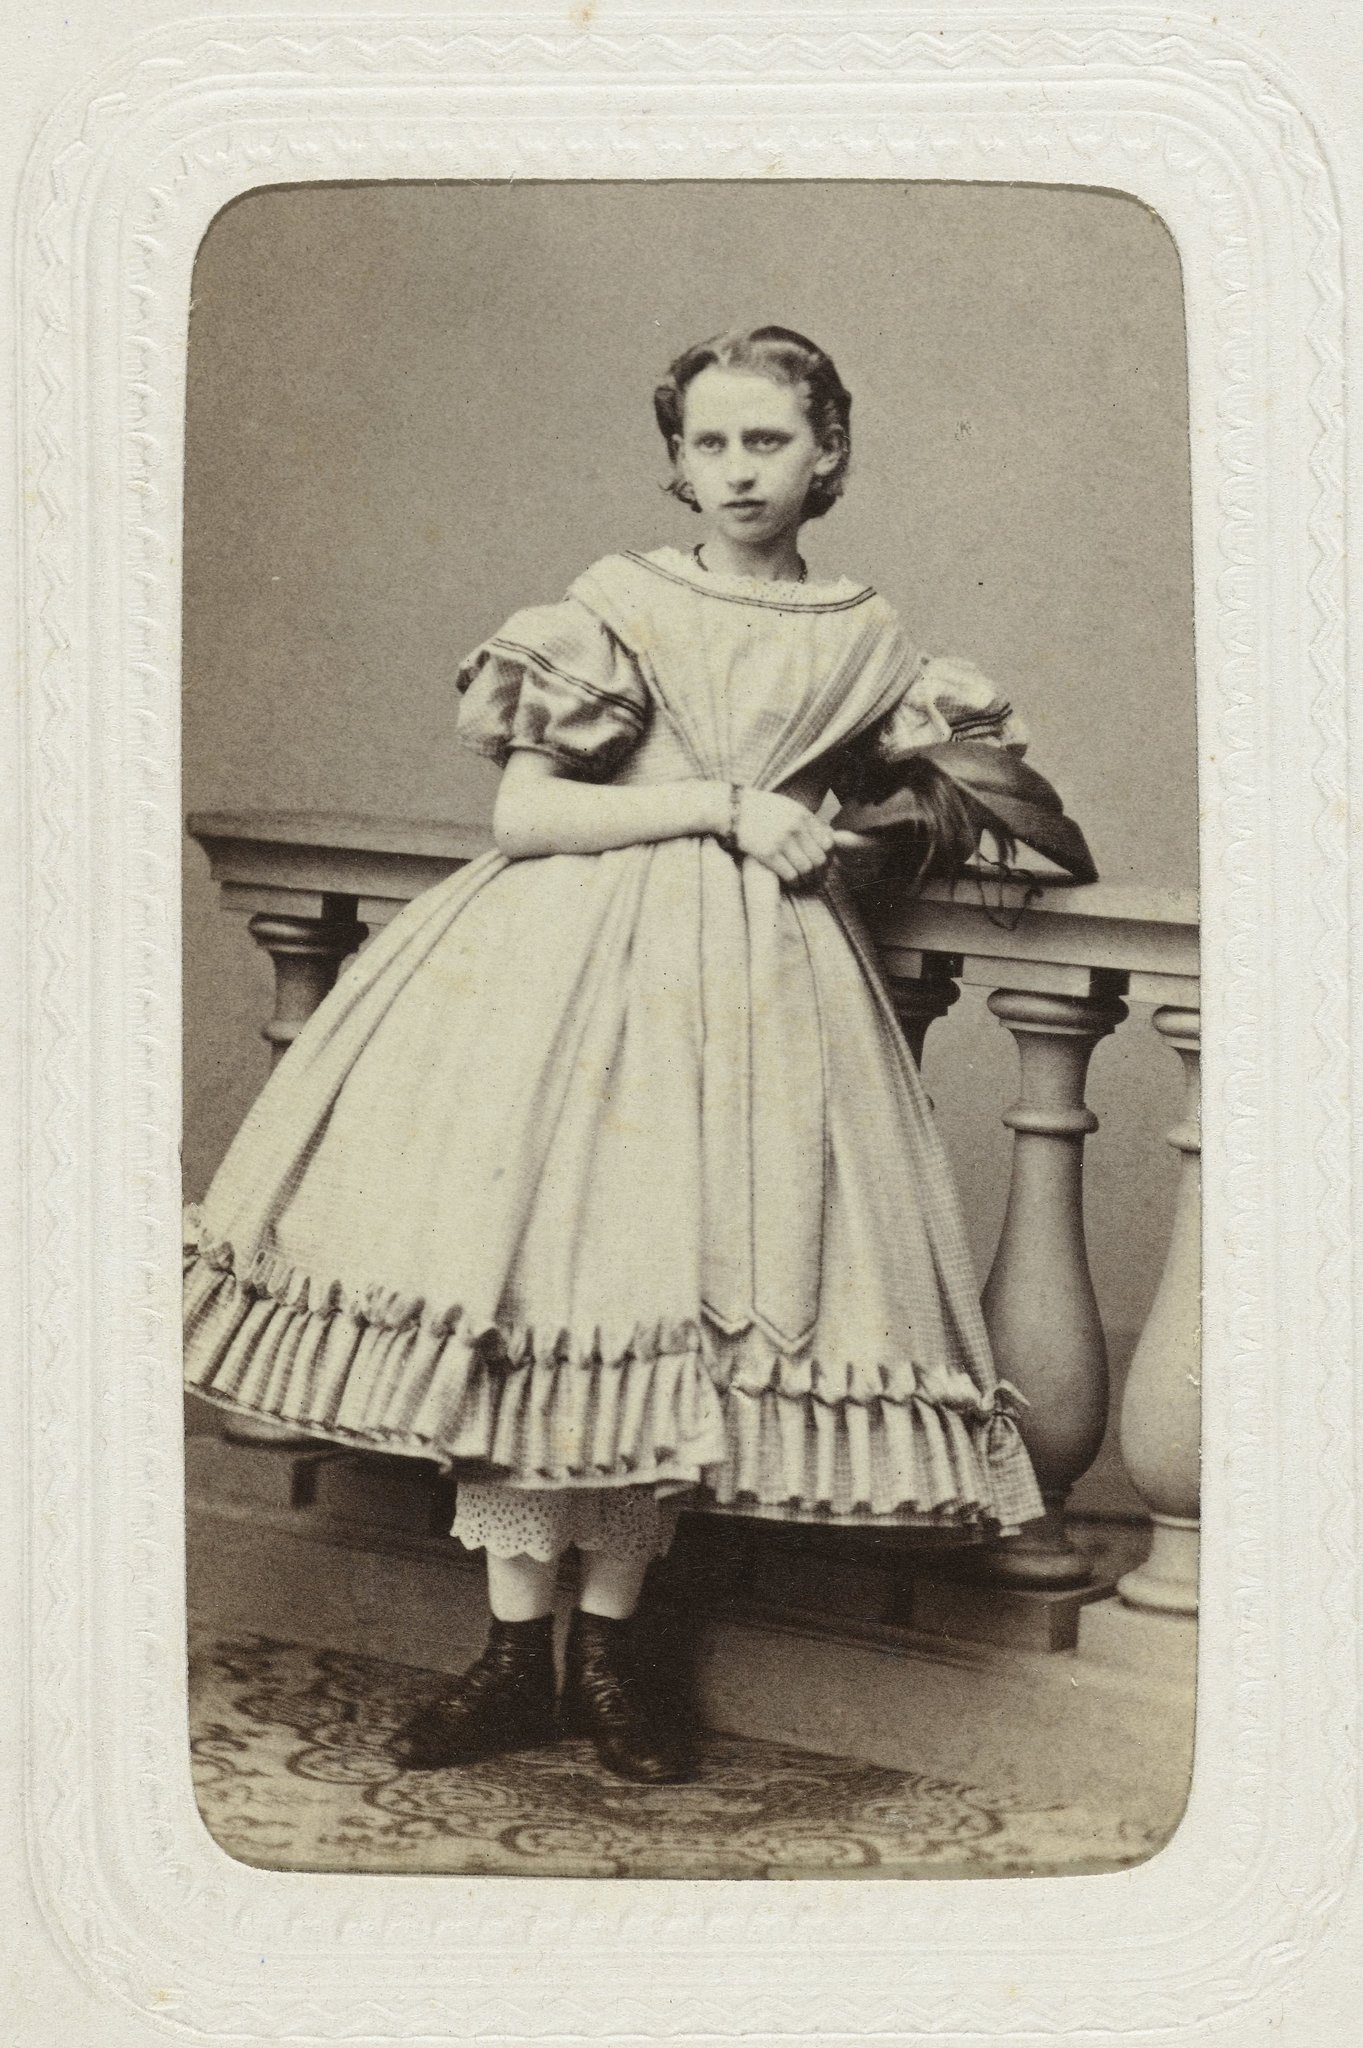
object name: carte de visite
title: Studioportret van een meisje in een bolle jurk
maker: willem tinker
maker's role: fotograaf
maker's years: 1816-1894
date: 1863-1866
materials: cardboard, paper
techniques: albumen print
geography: amsterdam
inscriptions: name: ‘W. Tinker, Amsterdasm’